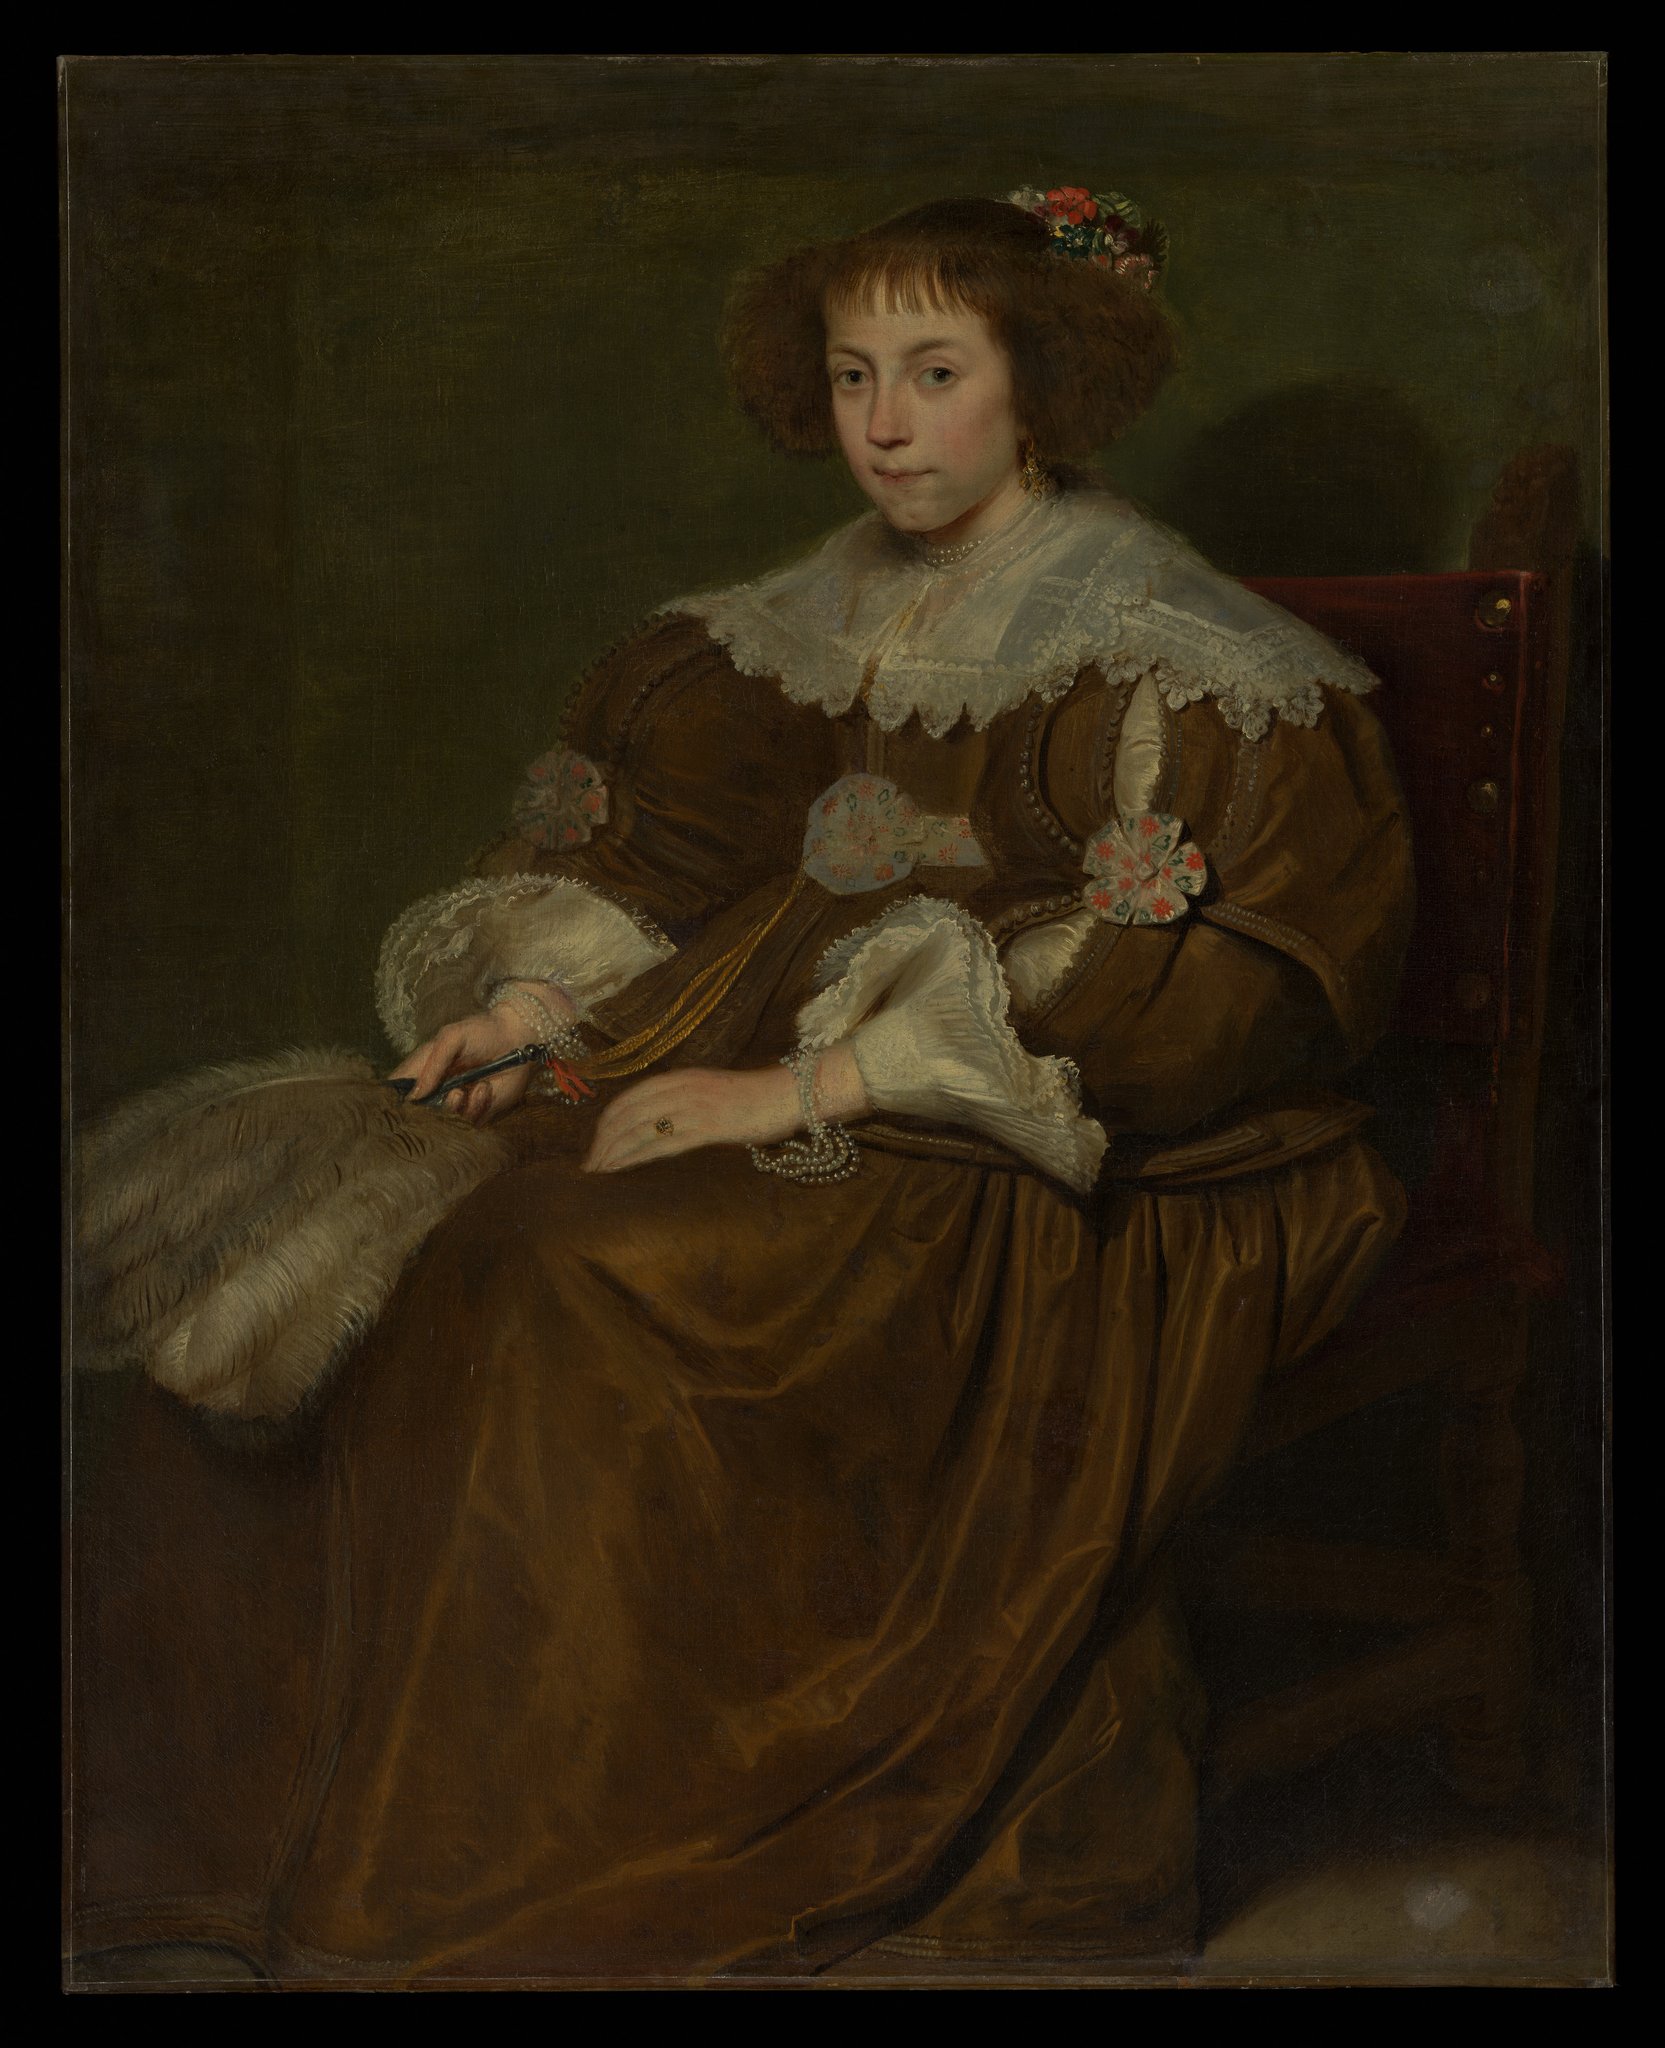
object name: painting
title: Portrait of a Young Woman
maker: cornelis de vos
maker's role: artist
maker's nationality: flemish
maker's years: 1584-1651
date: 1603-1651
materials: canvas, oil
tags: fans,portraits,women